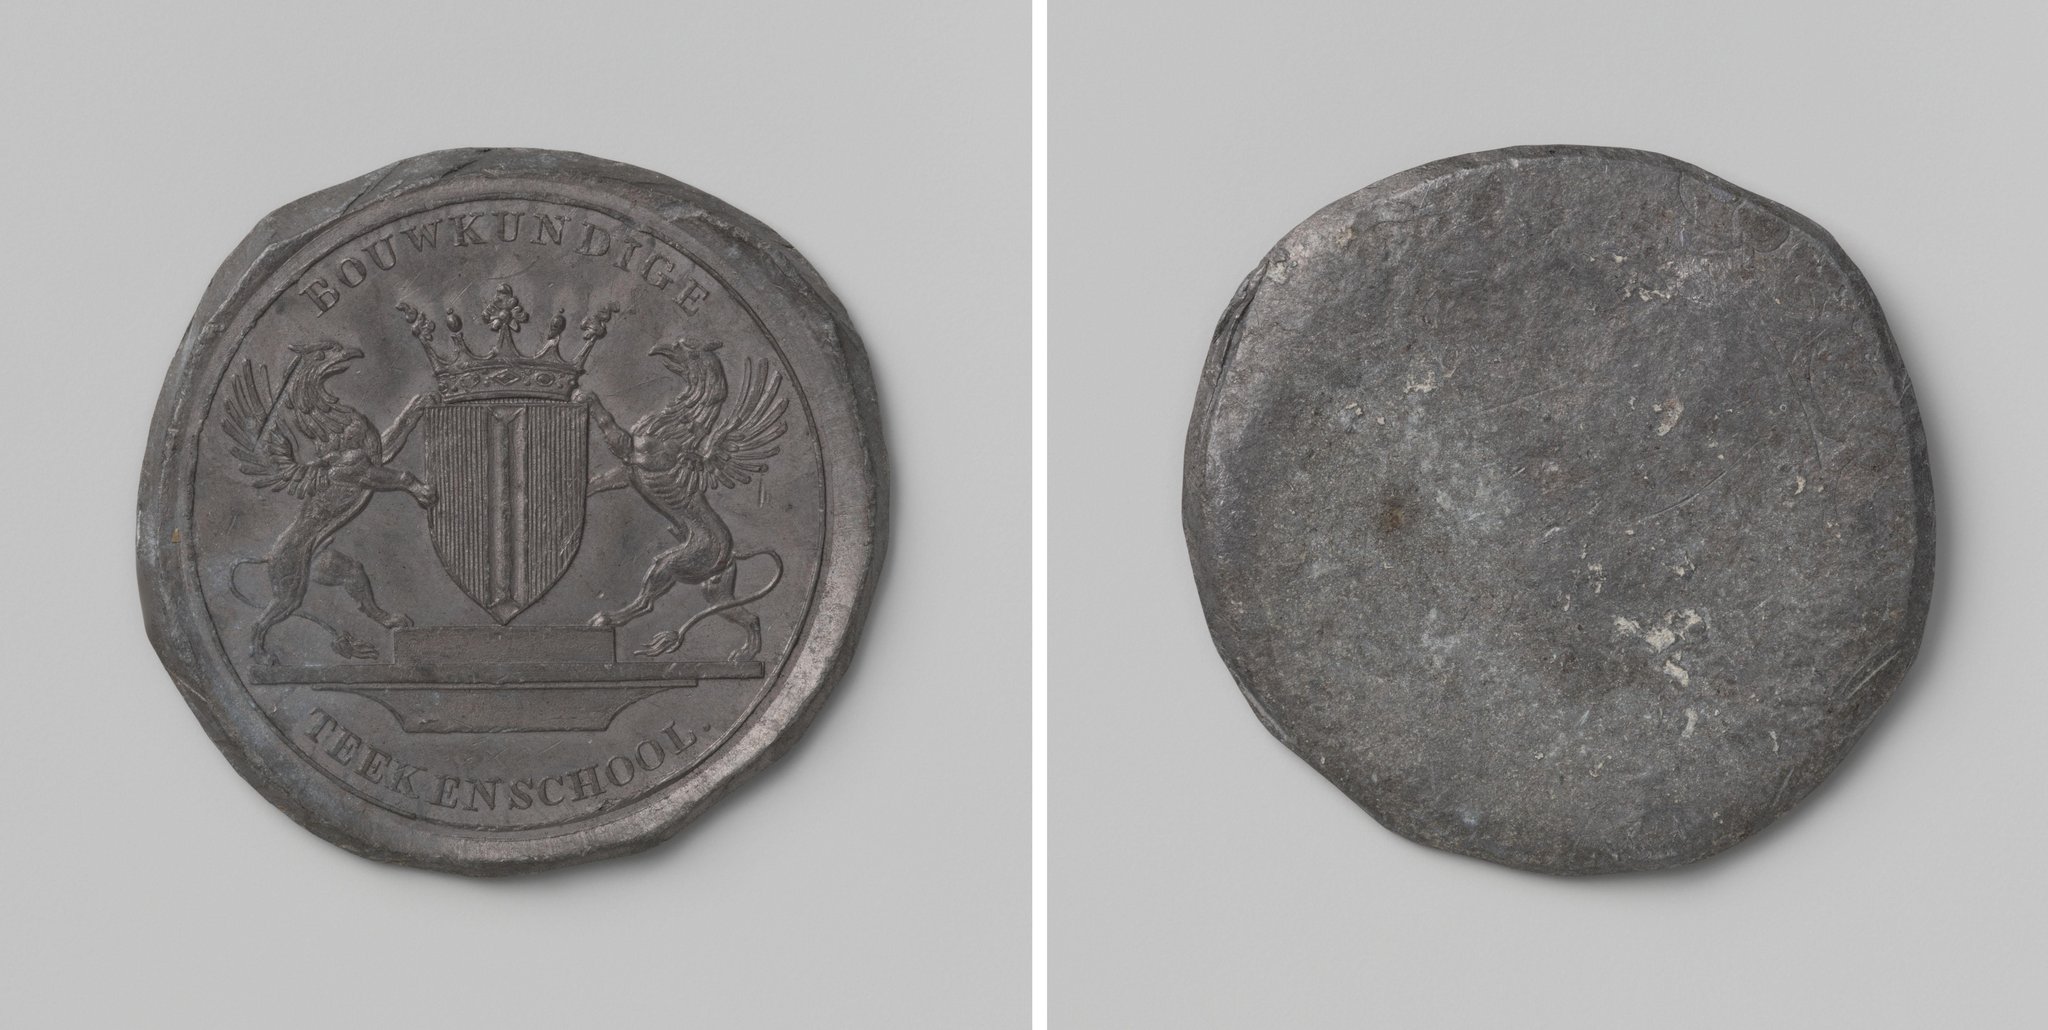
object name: medal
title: Bouwkundige tekenschool te Delft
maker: Anonymous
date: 1750-1850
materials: lead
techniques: striking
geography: netherlands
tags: delft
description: Eenzijdige loden penning. Voorzijde: gekroond wapenschild, gedragen door twee griffioenen binnen omschrift. Keerzijde: blanco